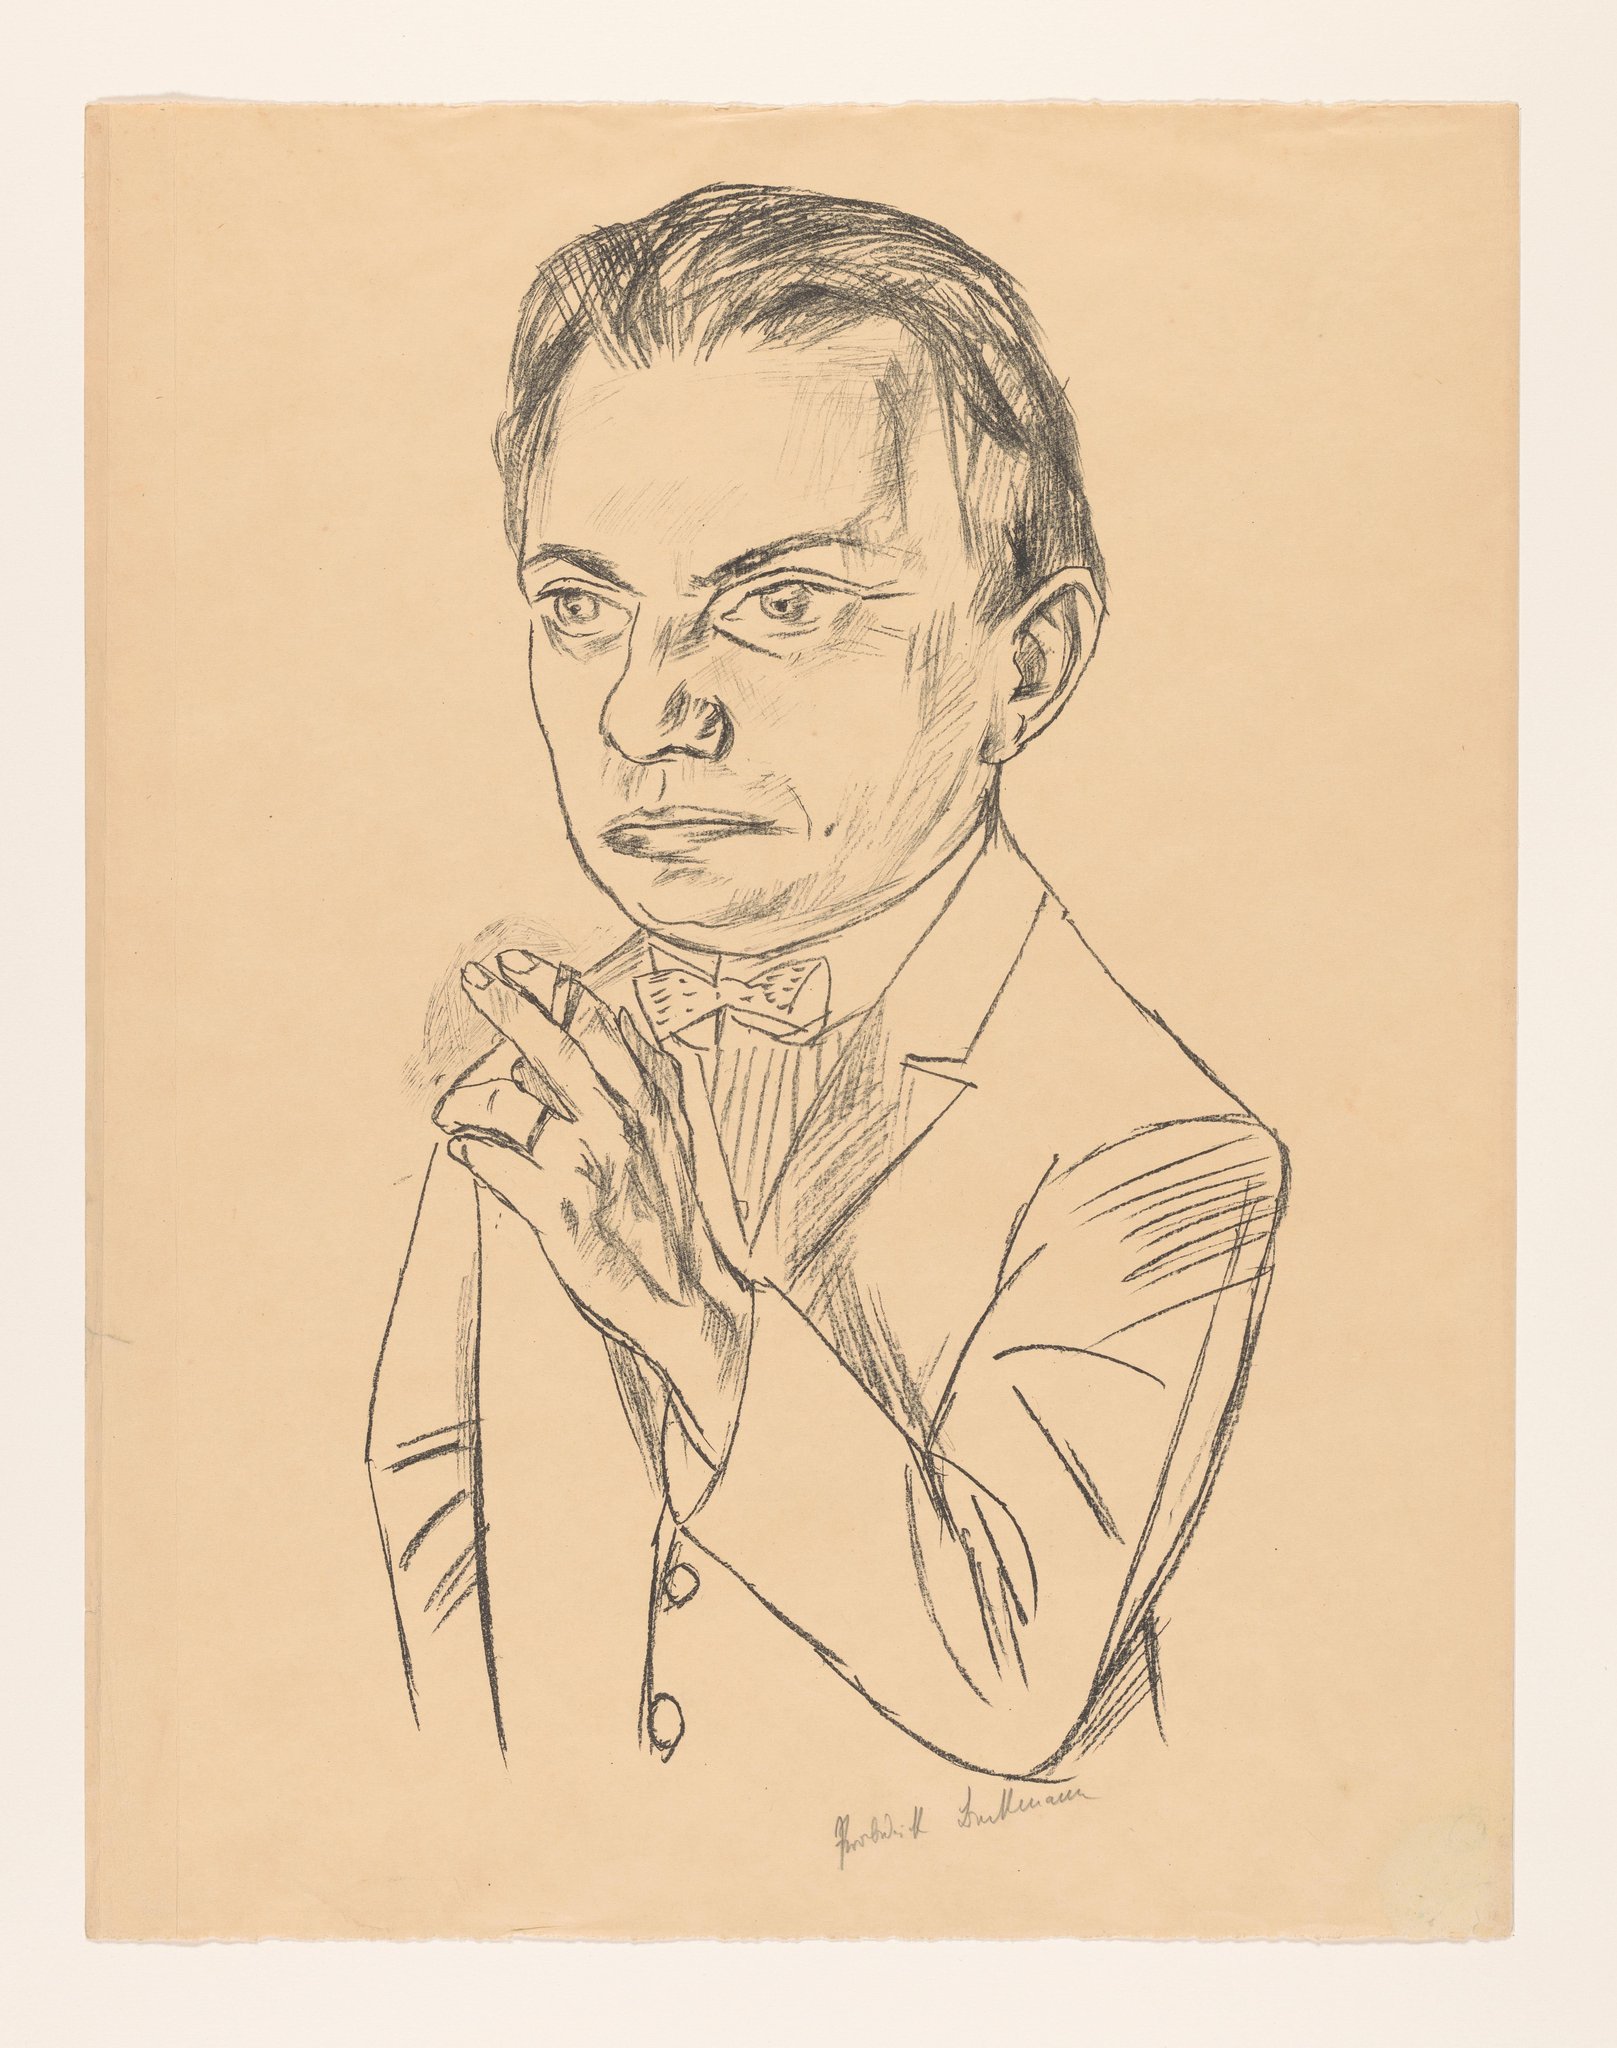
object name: print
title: Zelfportret met sigaret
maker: max beckmann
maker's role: print maker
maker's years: 1884-1950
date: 1894-1950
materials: paper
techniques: lithograph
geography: germany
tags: portrait, self-portrait of artist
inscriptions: collector's mark: Lugt 2228